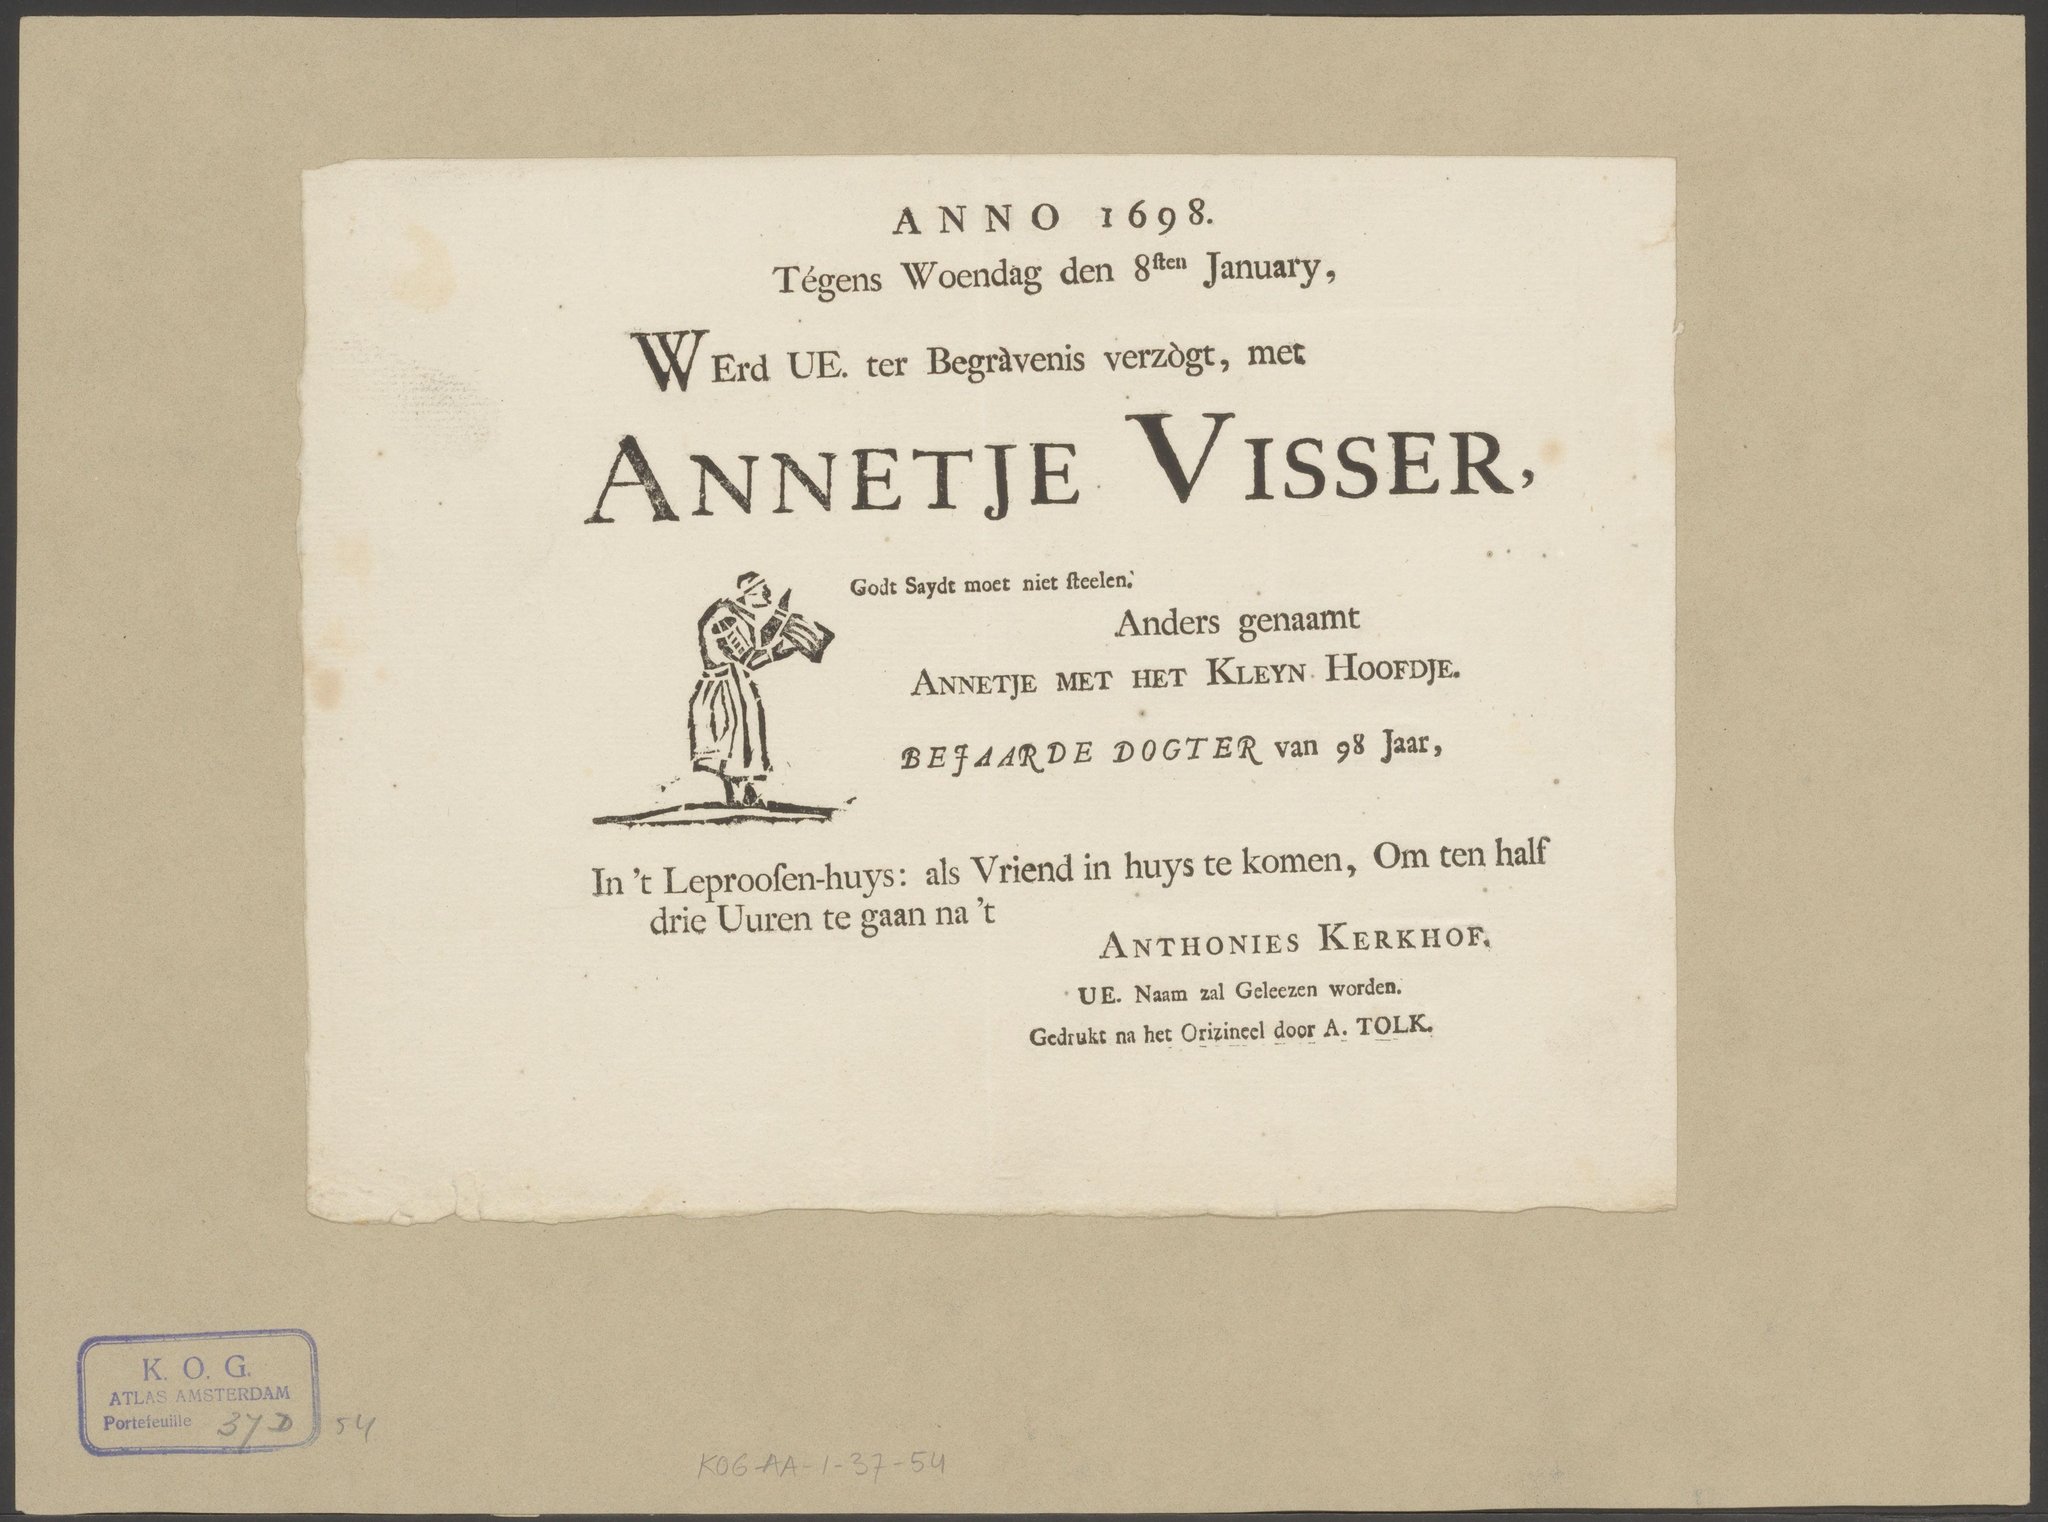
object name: invitation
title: Uitnodiging voor de begrafenis van Annetje Visser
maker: a. tolk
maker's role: printer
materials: paper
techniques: letterpress printing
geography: northern netherlands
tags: burial, historical persons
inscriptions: collector's mark: Lugt 1641b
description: Onderwerpsrubriek binnen de Atlas Amsterdam: Armwezen en liefdadige instellingen: I. Stadsinrichtingen: Leprozen- of Lazarushuis, omgang van leprozen, regenten.